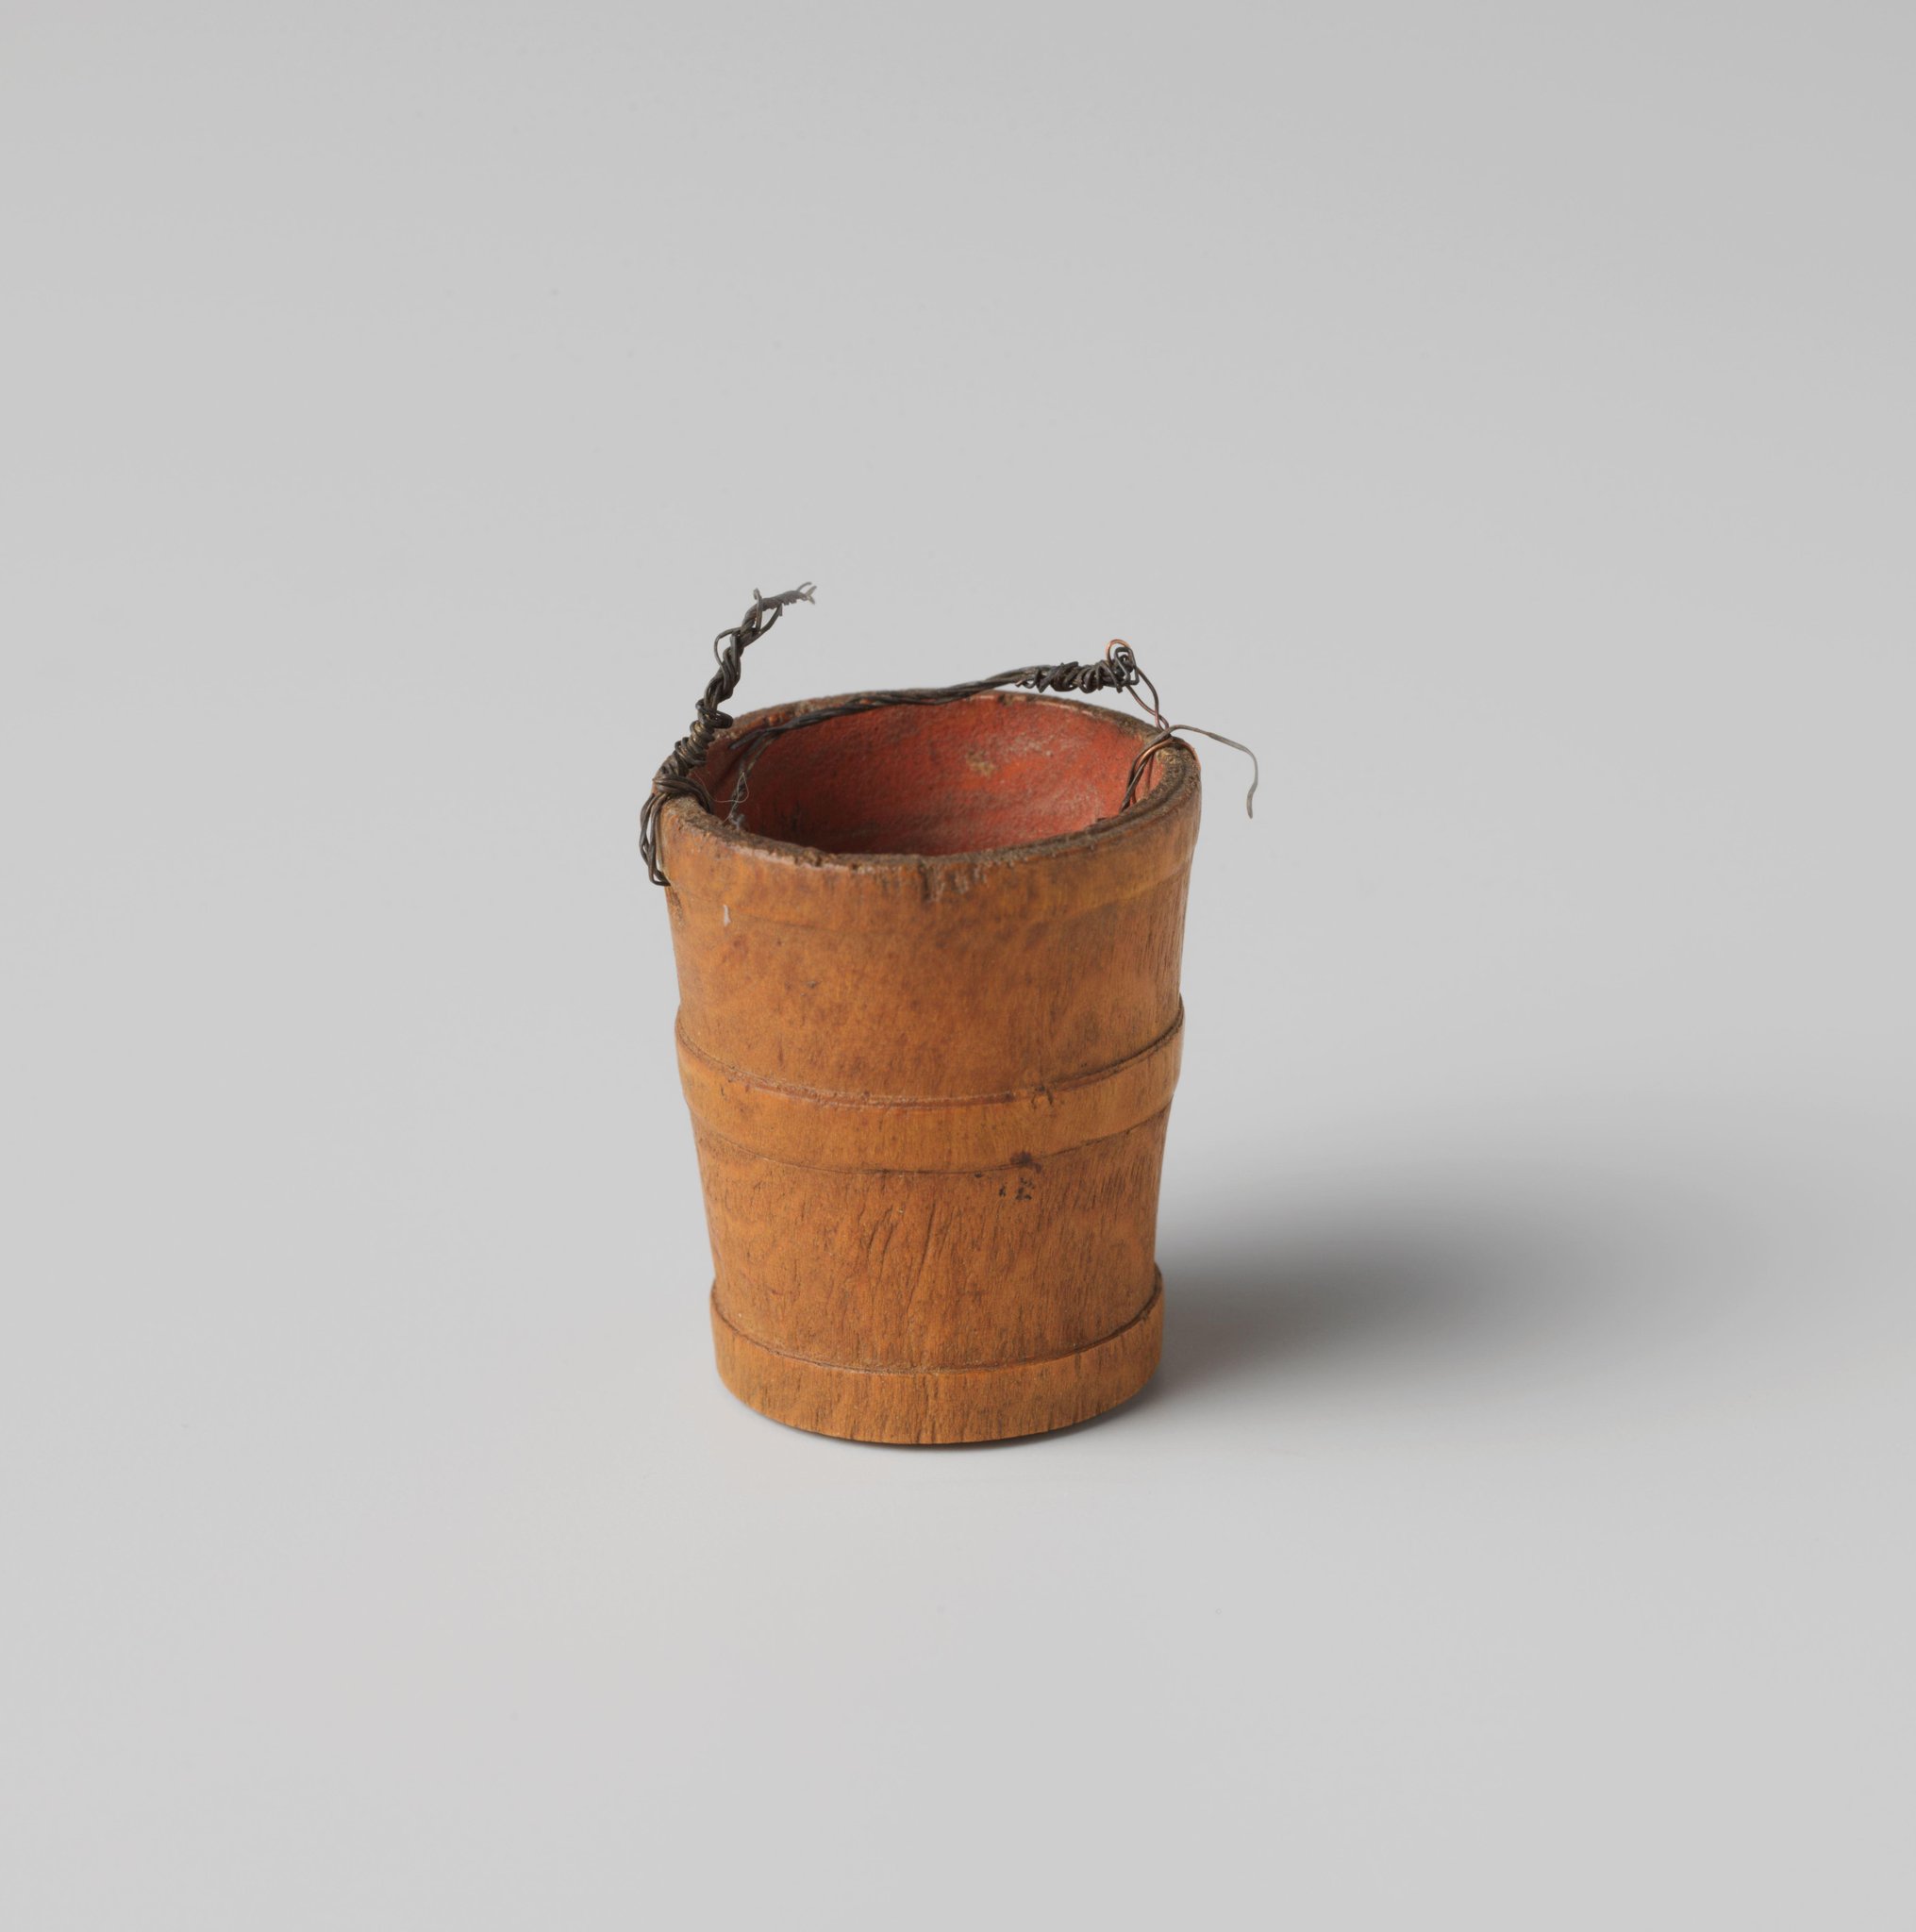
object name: pail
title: Emmer met drie profielen, de binnenzijde roodgeverfd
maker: Anonymous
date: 1700-1799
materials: wood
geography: amsterdam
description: Een emmer van gedraaid esdoornhout met drie profielen. Het hengsel van (later toegevoegd) ijzerdraad; aan de binnenkant roodgeverfd.